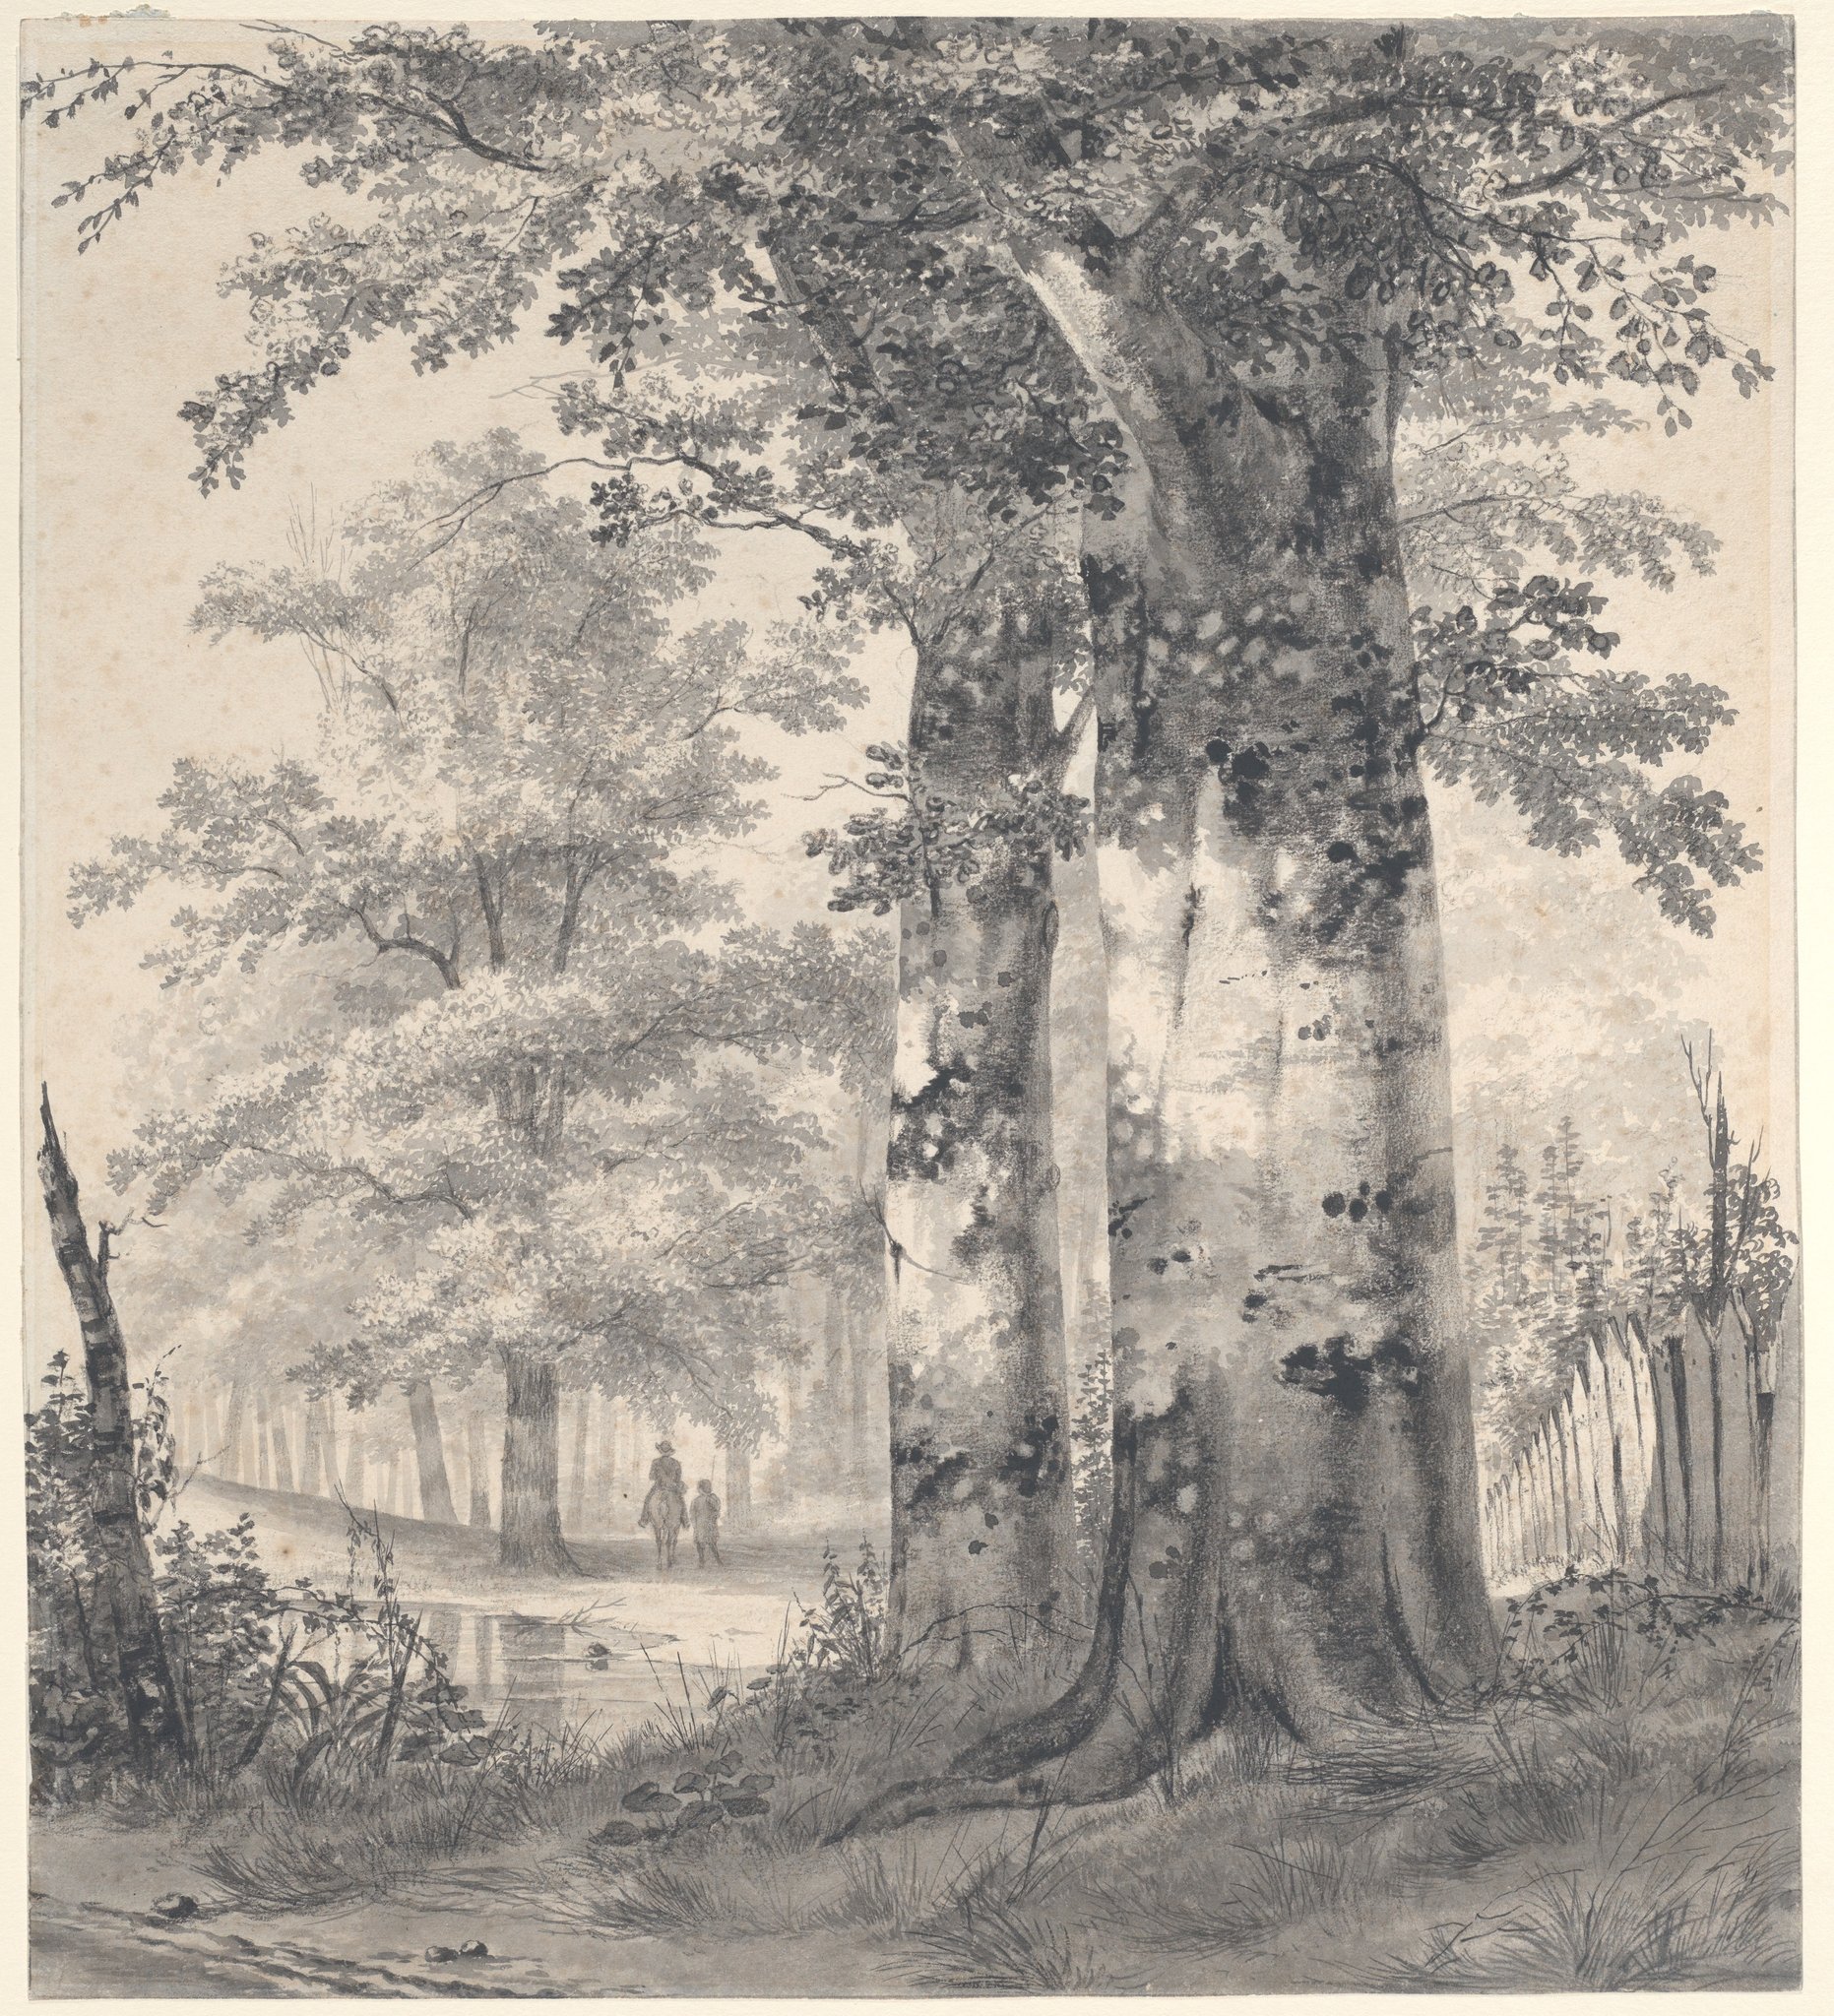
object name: drawing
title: Wooded Landscape with Figures by a Pond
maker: hendrik gerrit ten cate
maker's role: artist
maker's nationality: dutch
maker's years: 1803-1856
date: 1826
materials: chalk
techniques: brush, wash